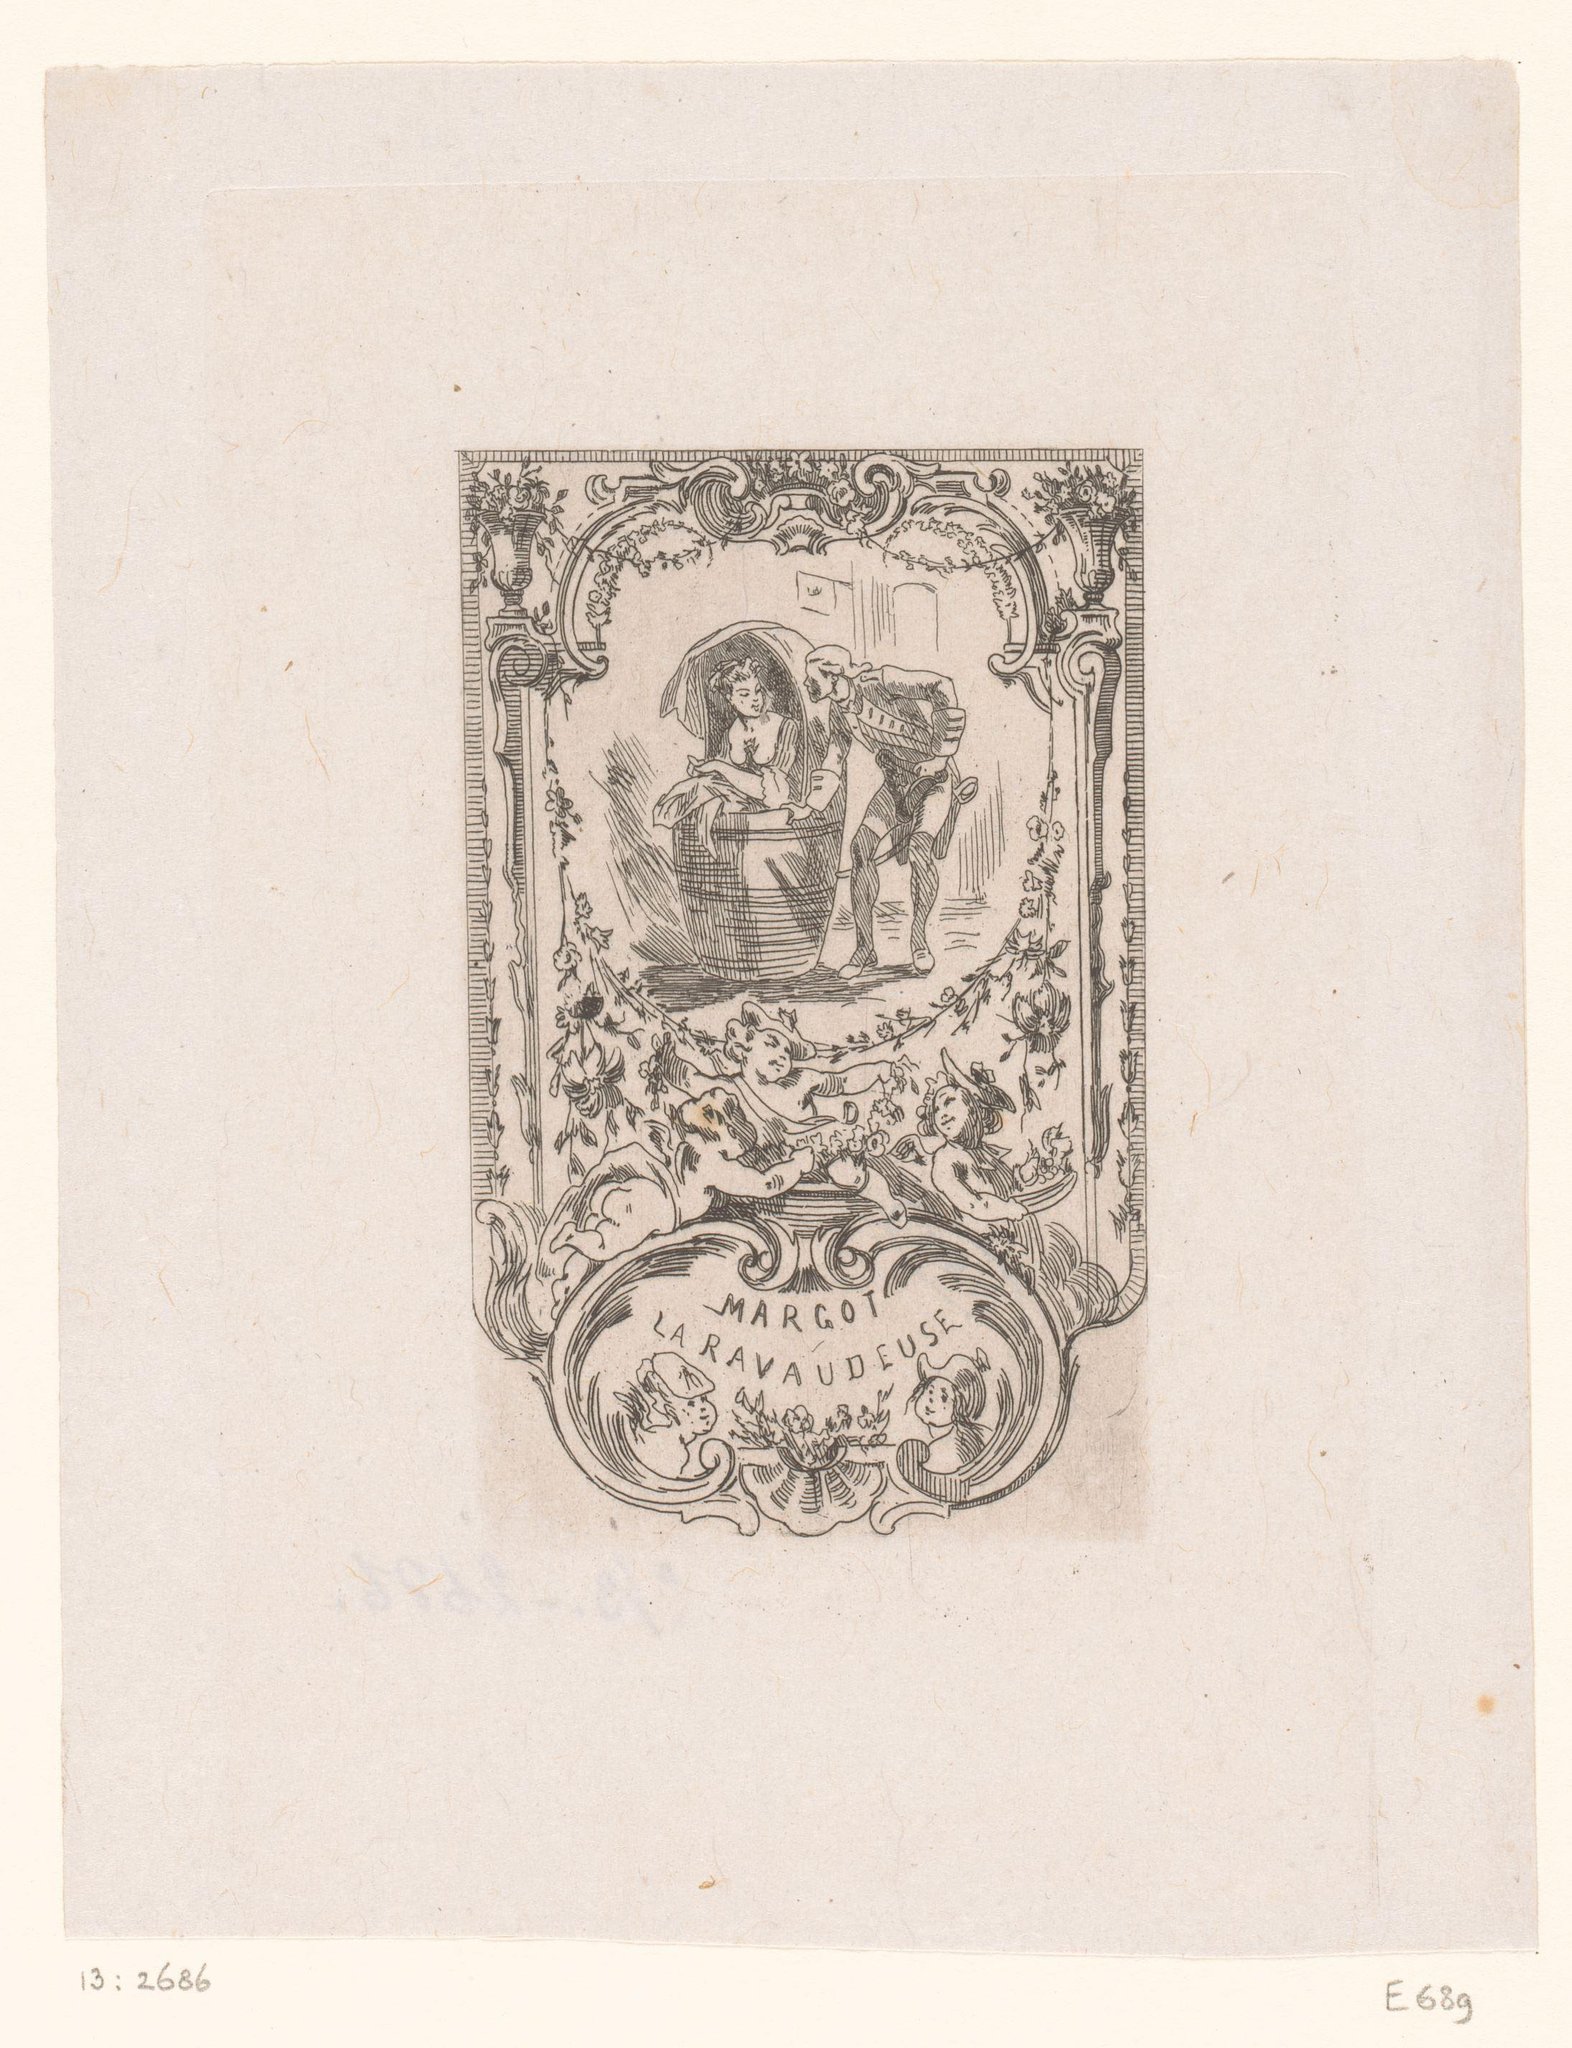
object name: print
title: Gesprek tussen een man en een vrouw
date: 1868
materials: paper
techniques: etching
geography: paris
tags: conversation, dialogue; conversation piece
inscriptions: collector's mark: Lugt 2228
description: Prent uit: Montbron, Fougeret de. Margot la Ravadeuse. Parijs: A. Poulet-Malassis, 1868.